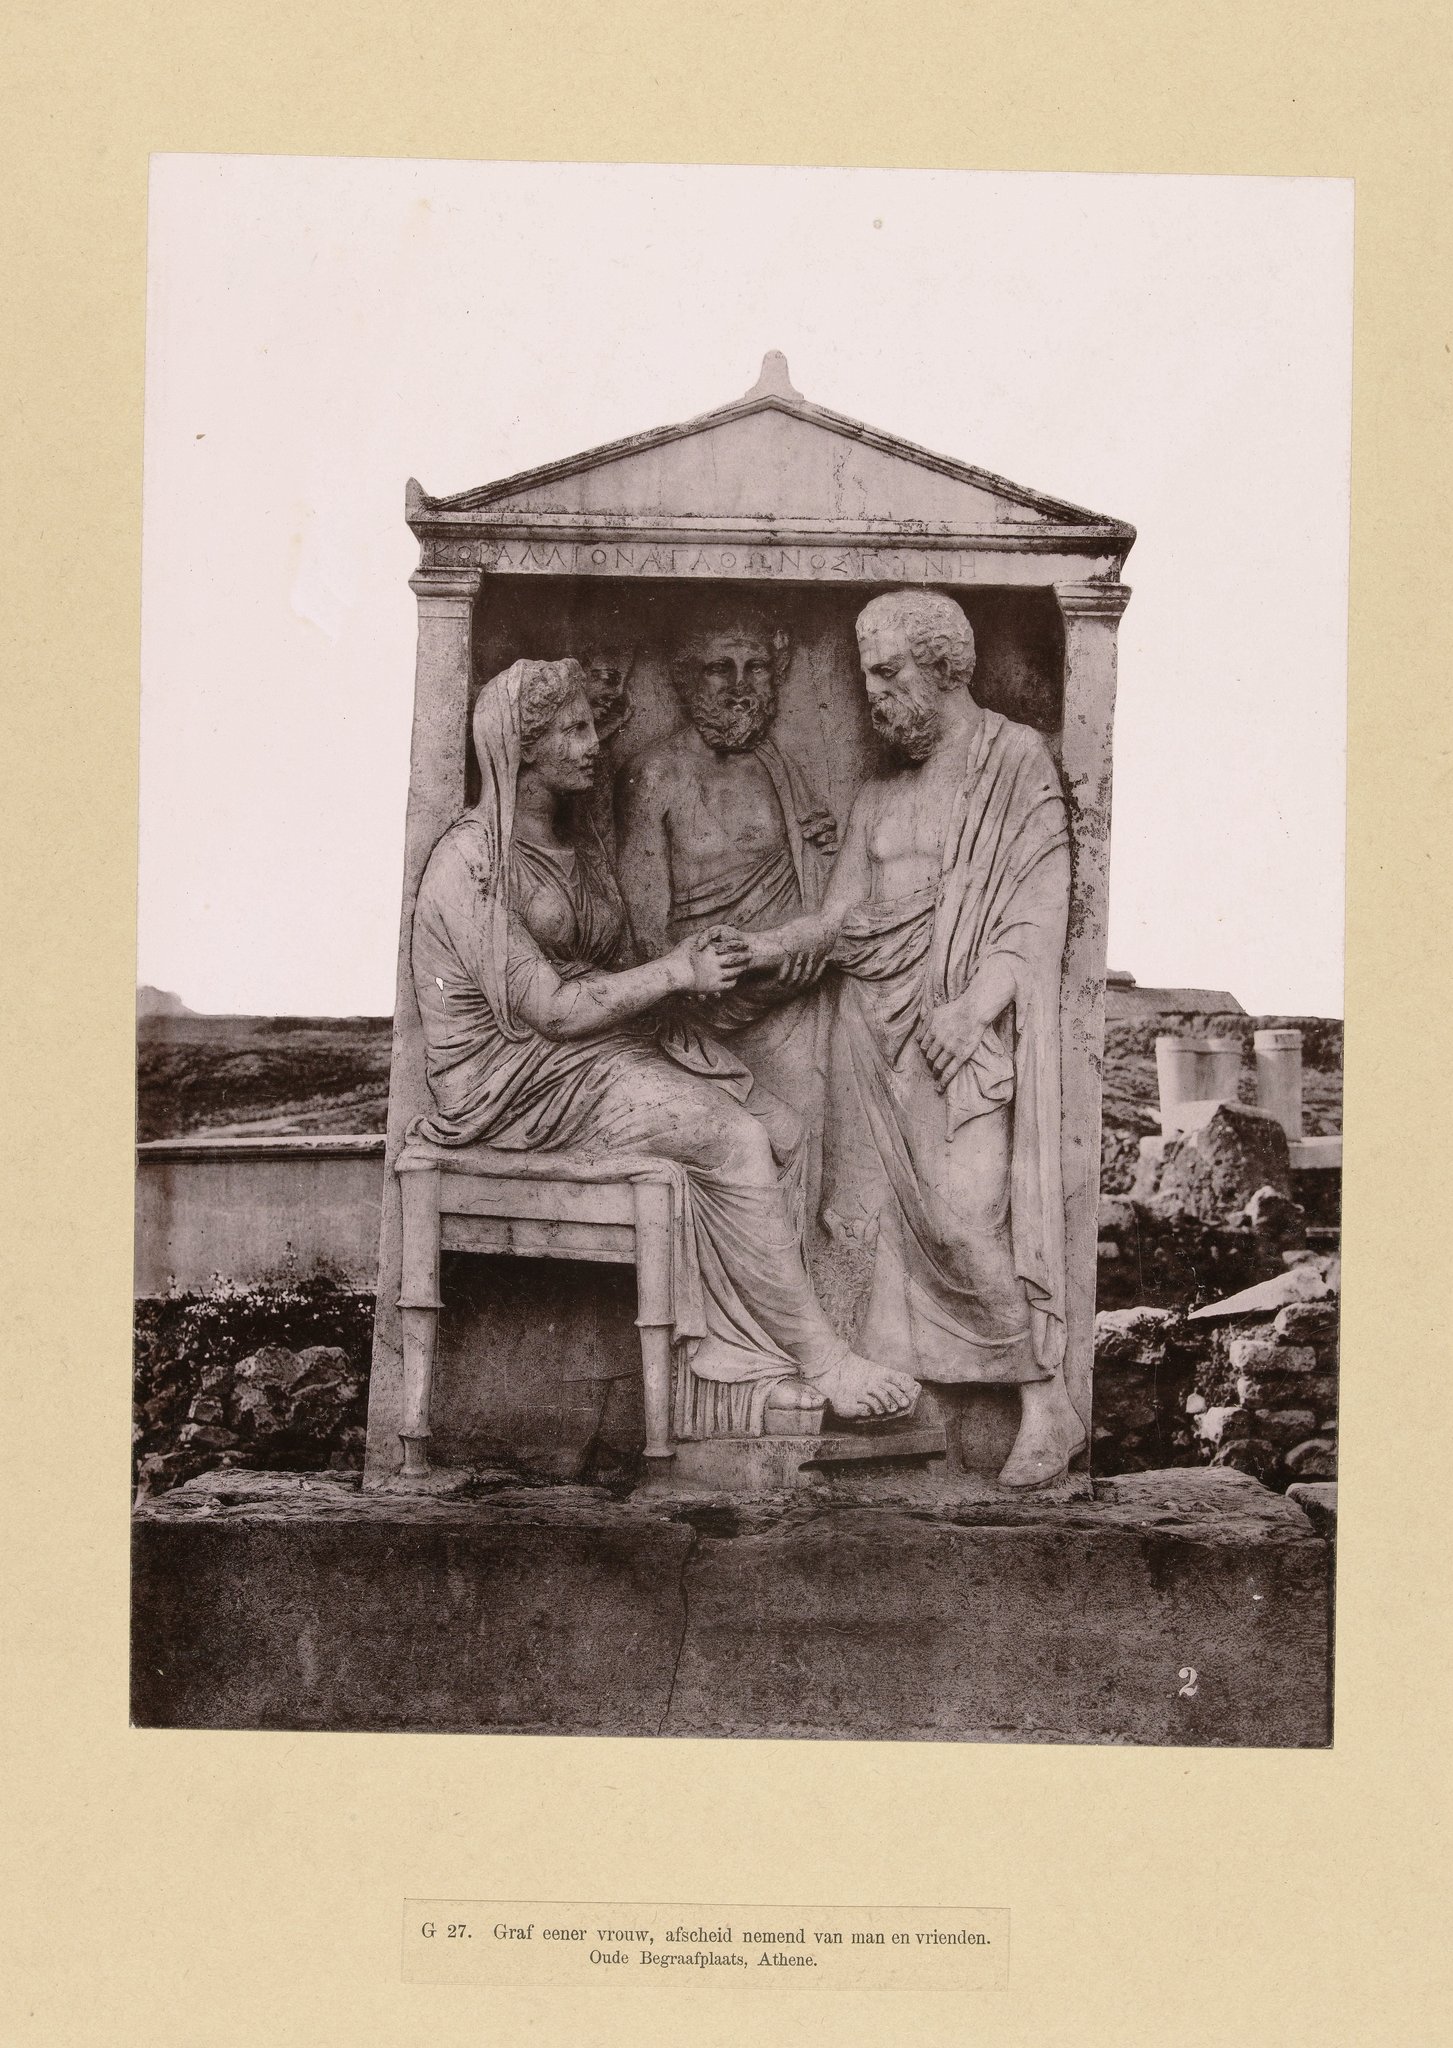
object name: photomechanical print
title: Grafsteen van een onbekende vrouw die afscheid neemt van man en vrienden, Athene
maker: Anonymous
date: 1890-1895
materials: cardboard, paper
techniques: photograph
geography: athens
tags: piece of sculpture, reproduction of a piece of sculpture, gravestone, tombstone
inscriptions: stamp: ‘Gemeentelijke bibliotheek/ Rotterdam’, check stamp: ‘Bristol/ L.M.’, number: ‘2’, title: ‘G 27. Graf eener vrouw, afscheid nemend van man en vrienden./ Oude Begraafplaats, Athene.’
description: Onderdeel van een groep door fotograaf Richard Polak op reis verzamelde foto’s. Deze fotomechanische afdruk is samen met andere op zijn reizen verzamelde foto's tentoongesteld bij de Rotterdamsche Kunstkring (1895), Arti en Amicitiae te Amsterdam (1897-1898?) en Societeit 't Collegie te Kampen (datum vooralsnog onbekend).